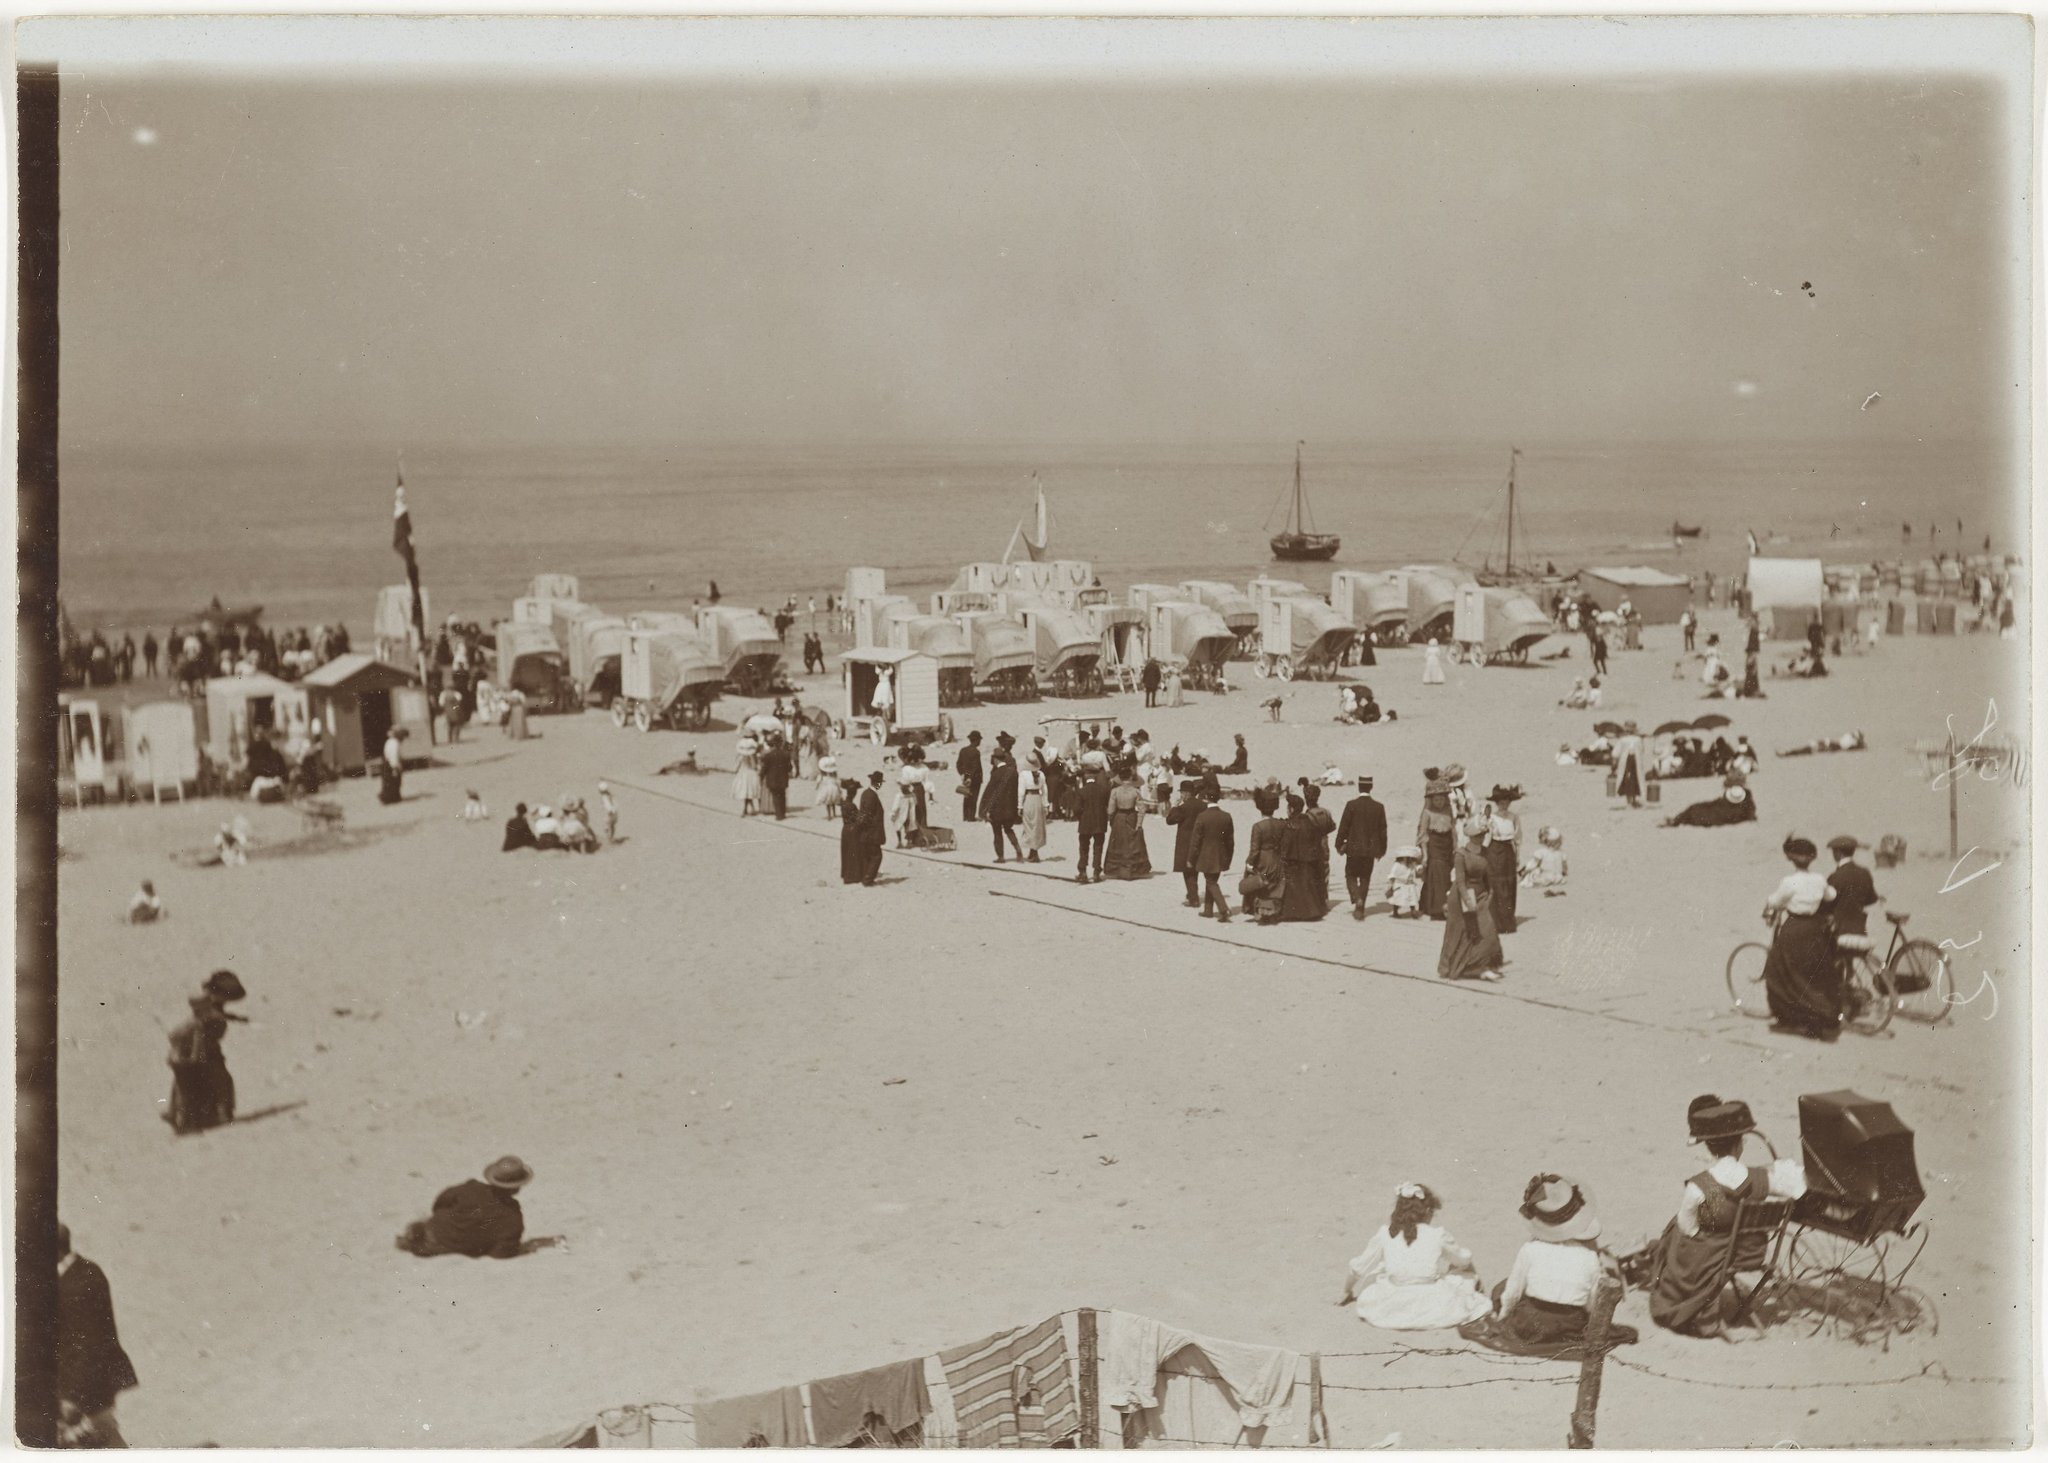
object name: photograph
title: Strand in Zandvoort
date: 1900-1905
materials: photographic support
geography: zandvoort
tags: beach (as place of recreation)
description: Strand van Zandvoort gezien vanaf de boulevard. Net aangklede dames en heren lopen richting zee, sommigen met een fiets, naar de badhokjes op wielen. Op zee twee bootjes.